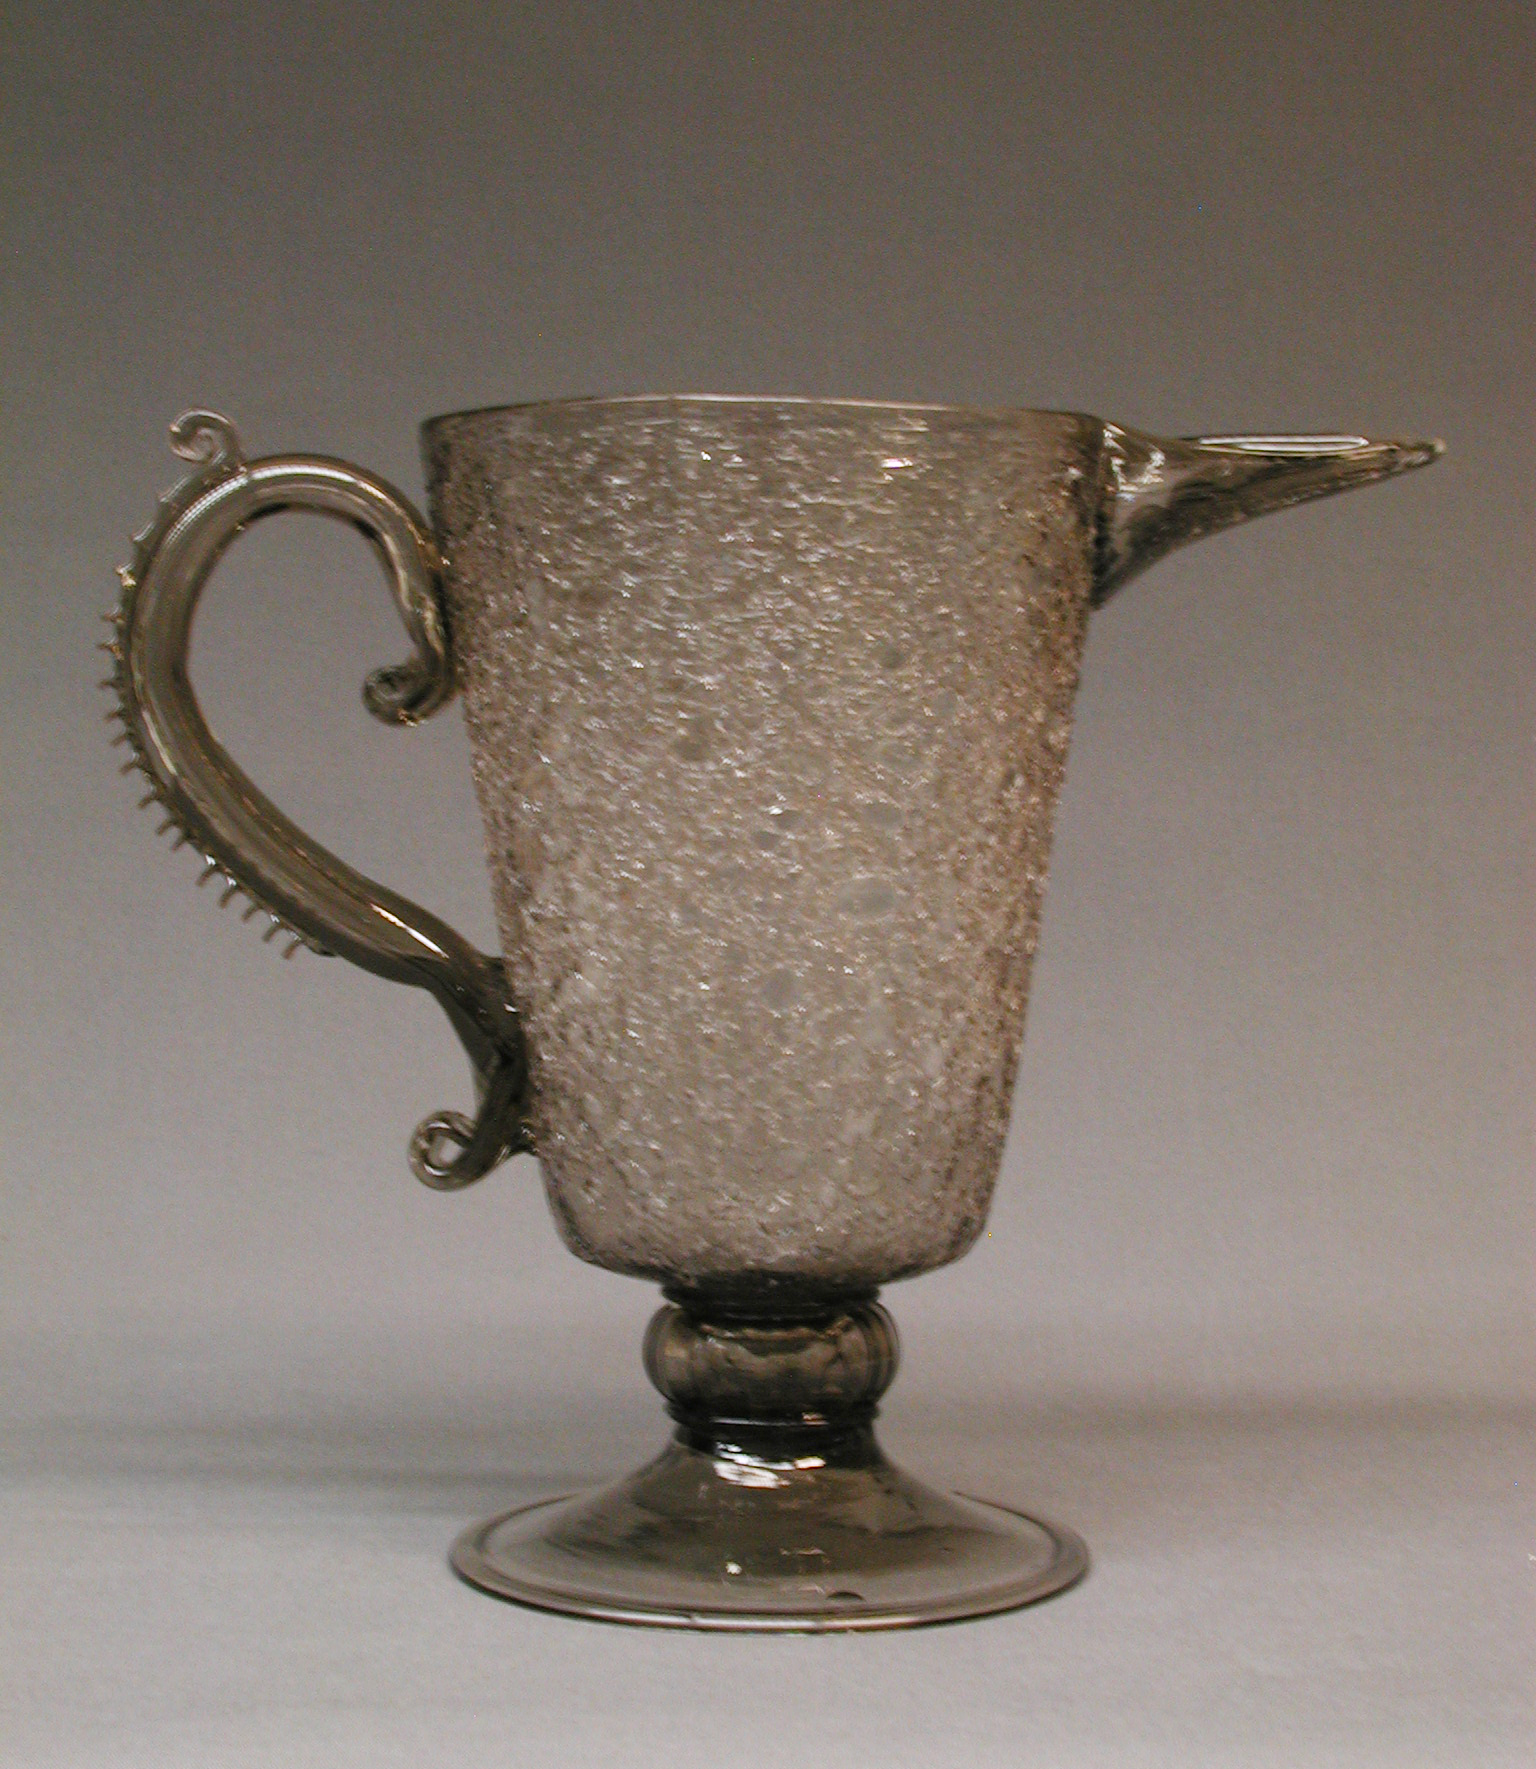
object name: jug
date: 1601-1700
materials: glass